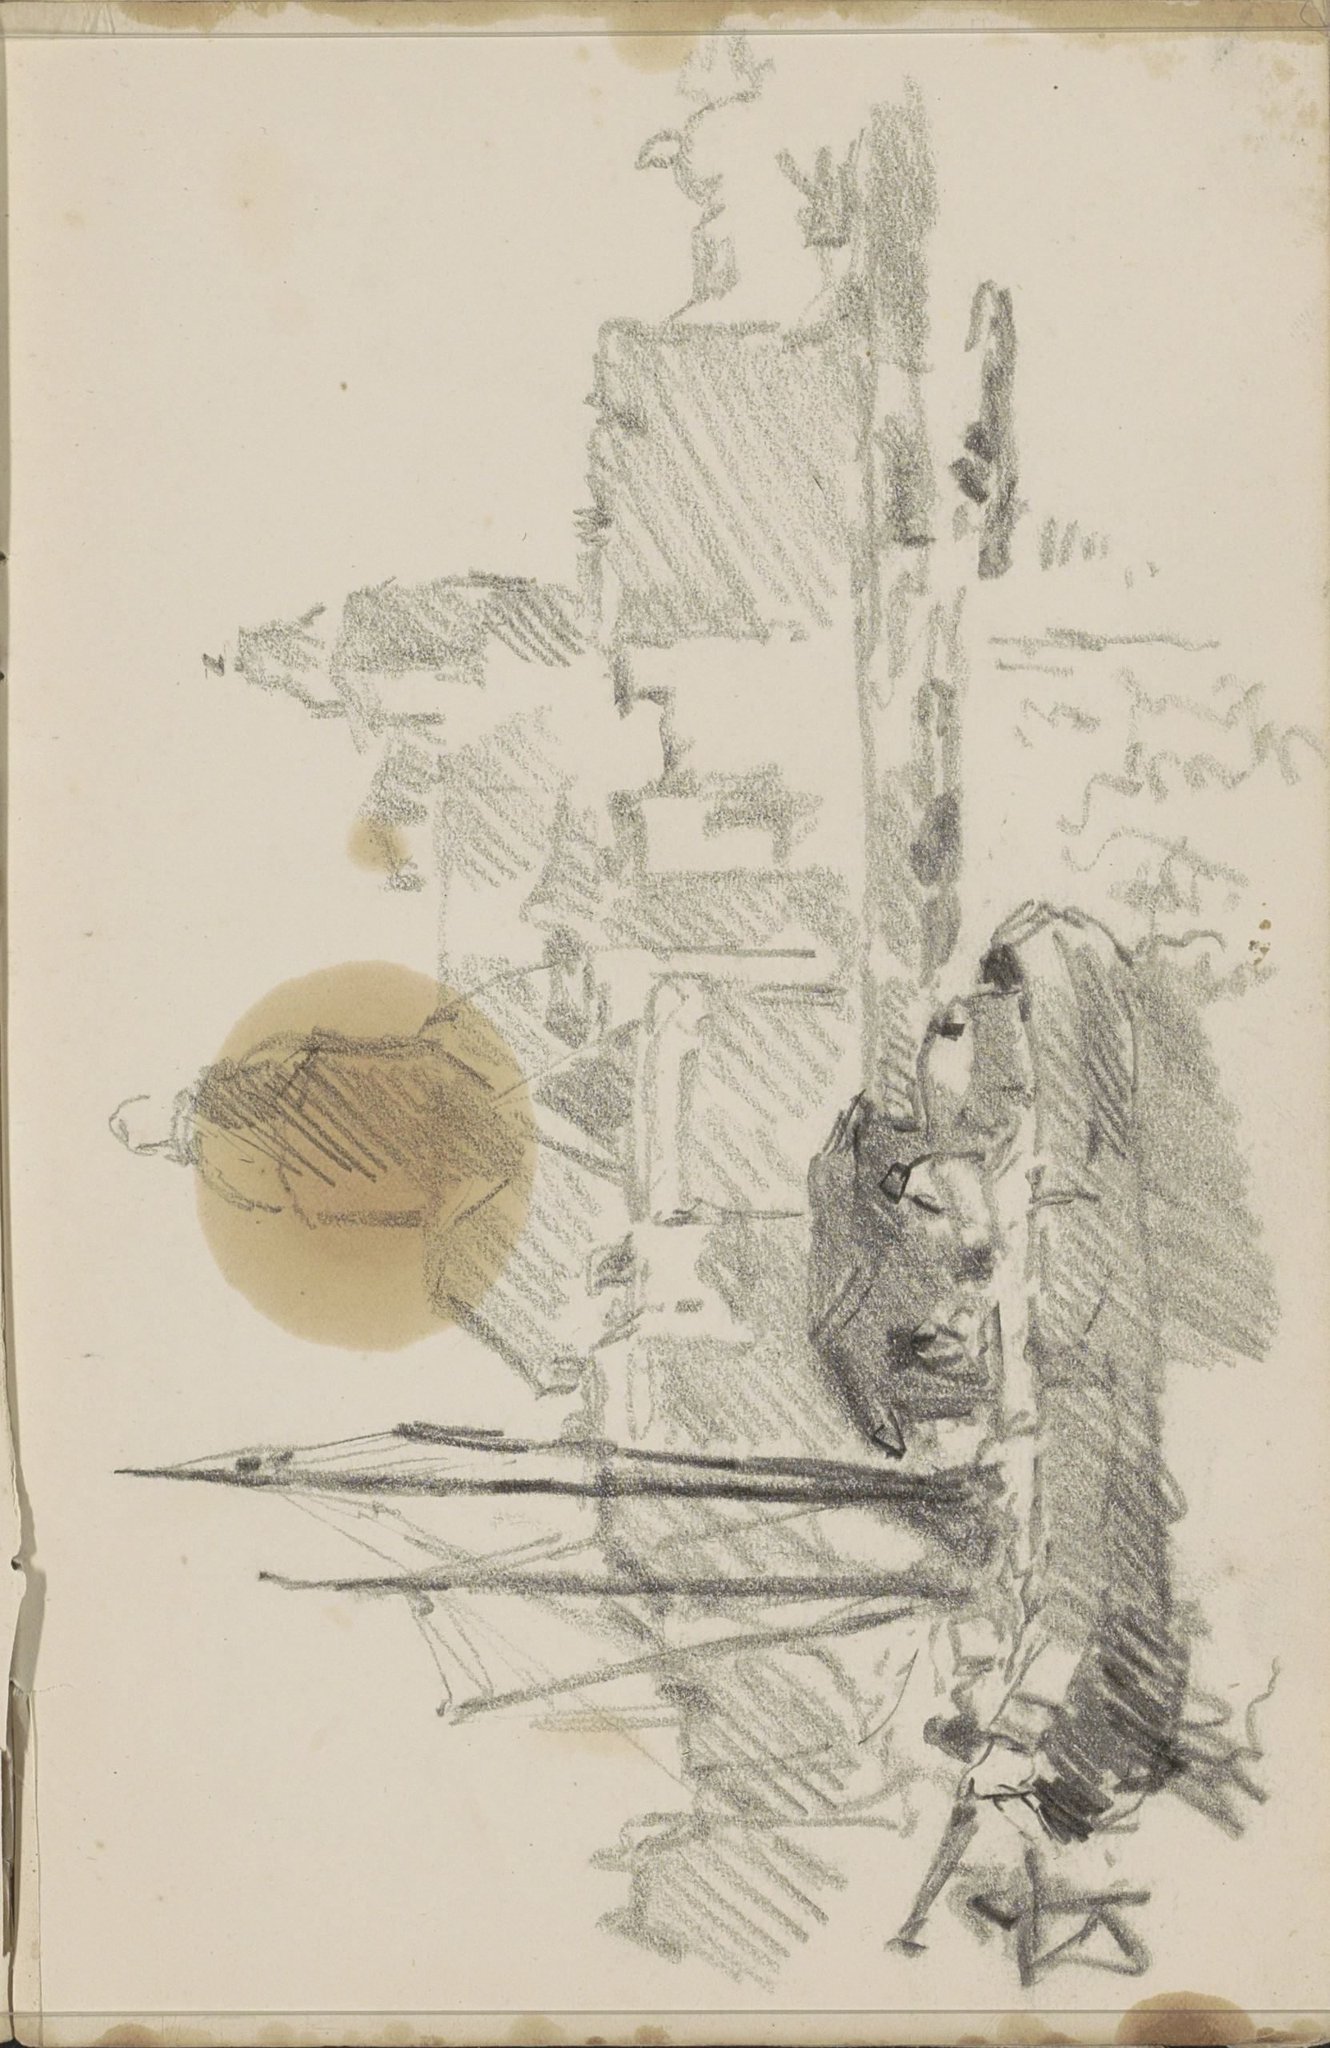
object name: sketchbook leaf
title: Open Havenfront met de Schreierstoren en Nicolaaskerk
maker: cornelis vreedenburgh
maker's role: draughtsman, print maker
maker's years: 1880-1946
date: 1890-1946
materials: chalk, paper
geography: amsterdam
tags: harbour, church (exterior)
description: Blad 26 recto uit een schetsboek met 45 bladen.